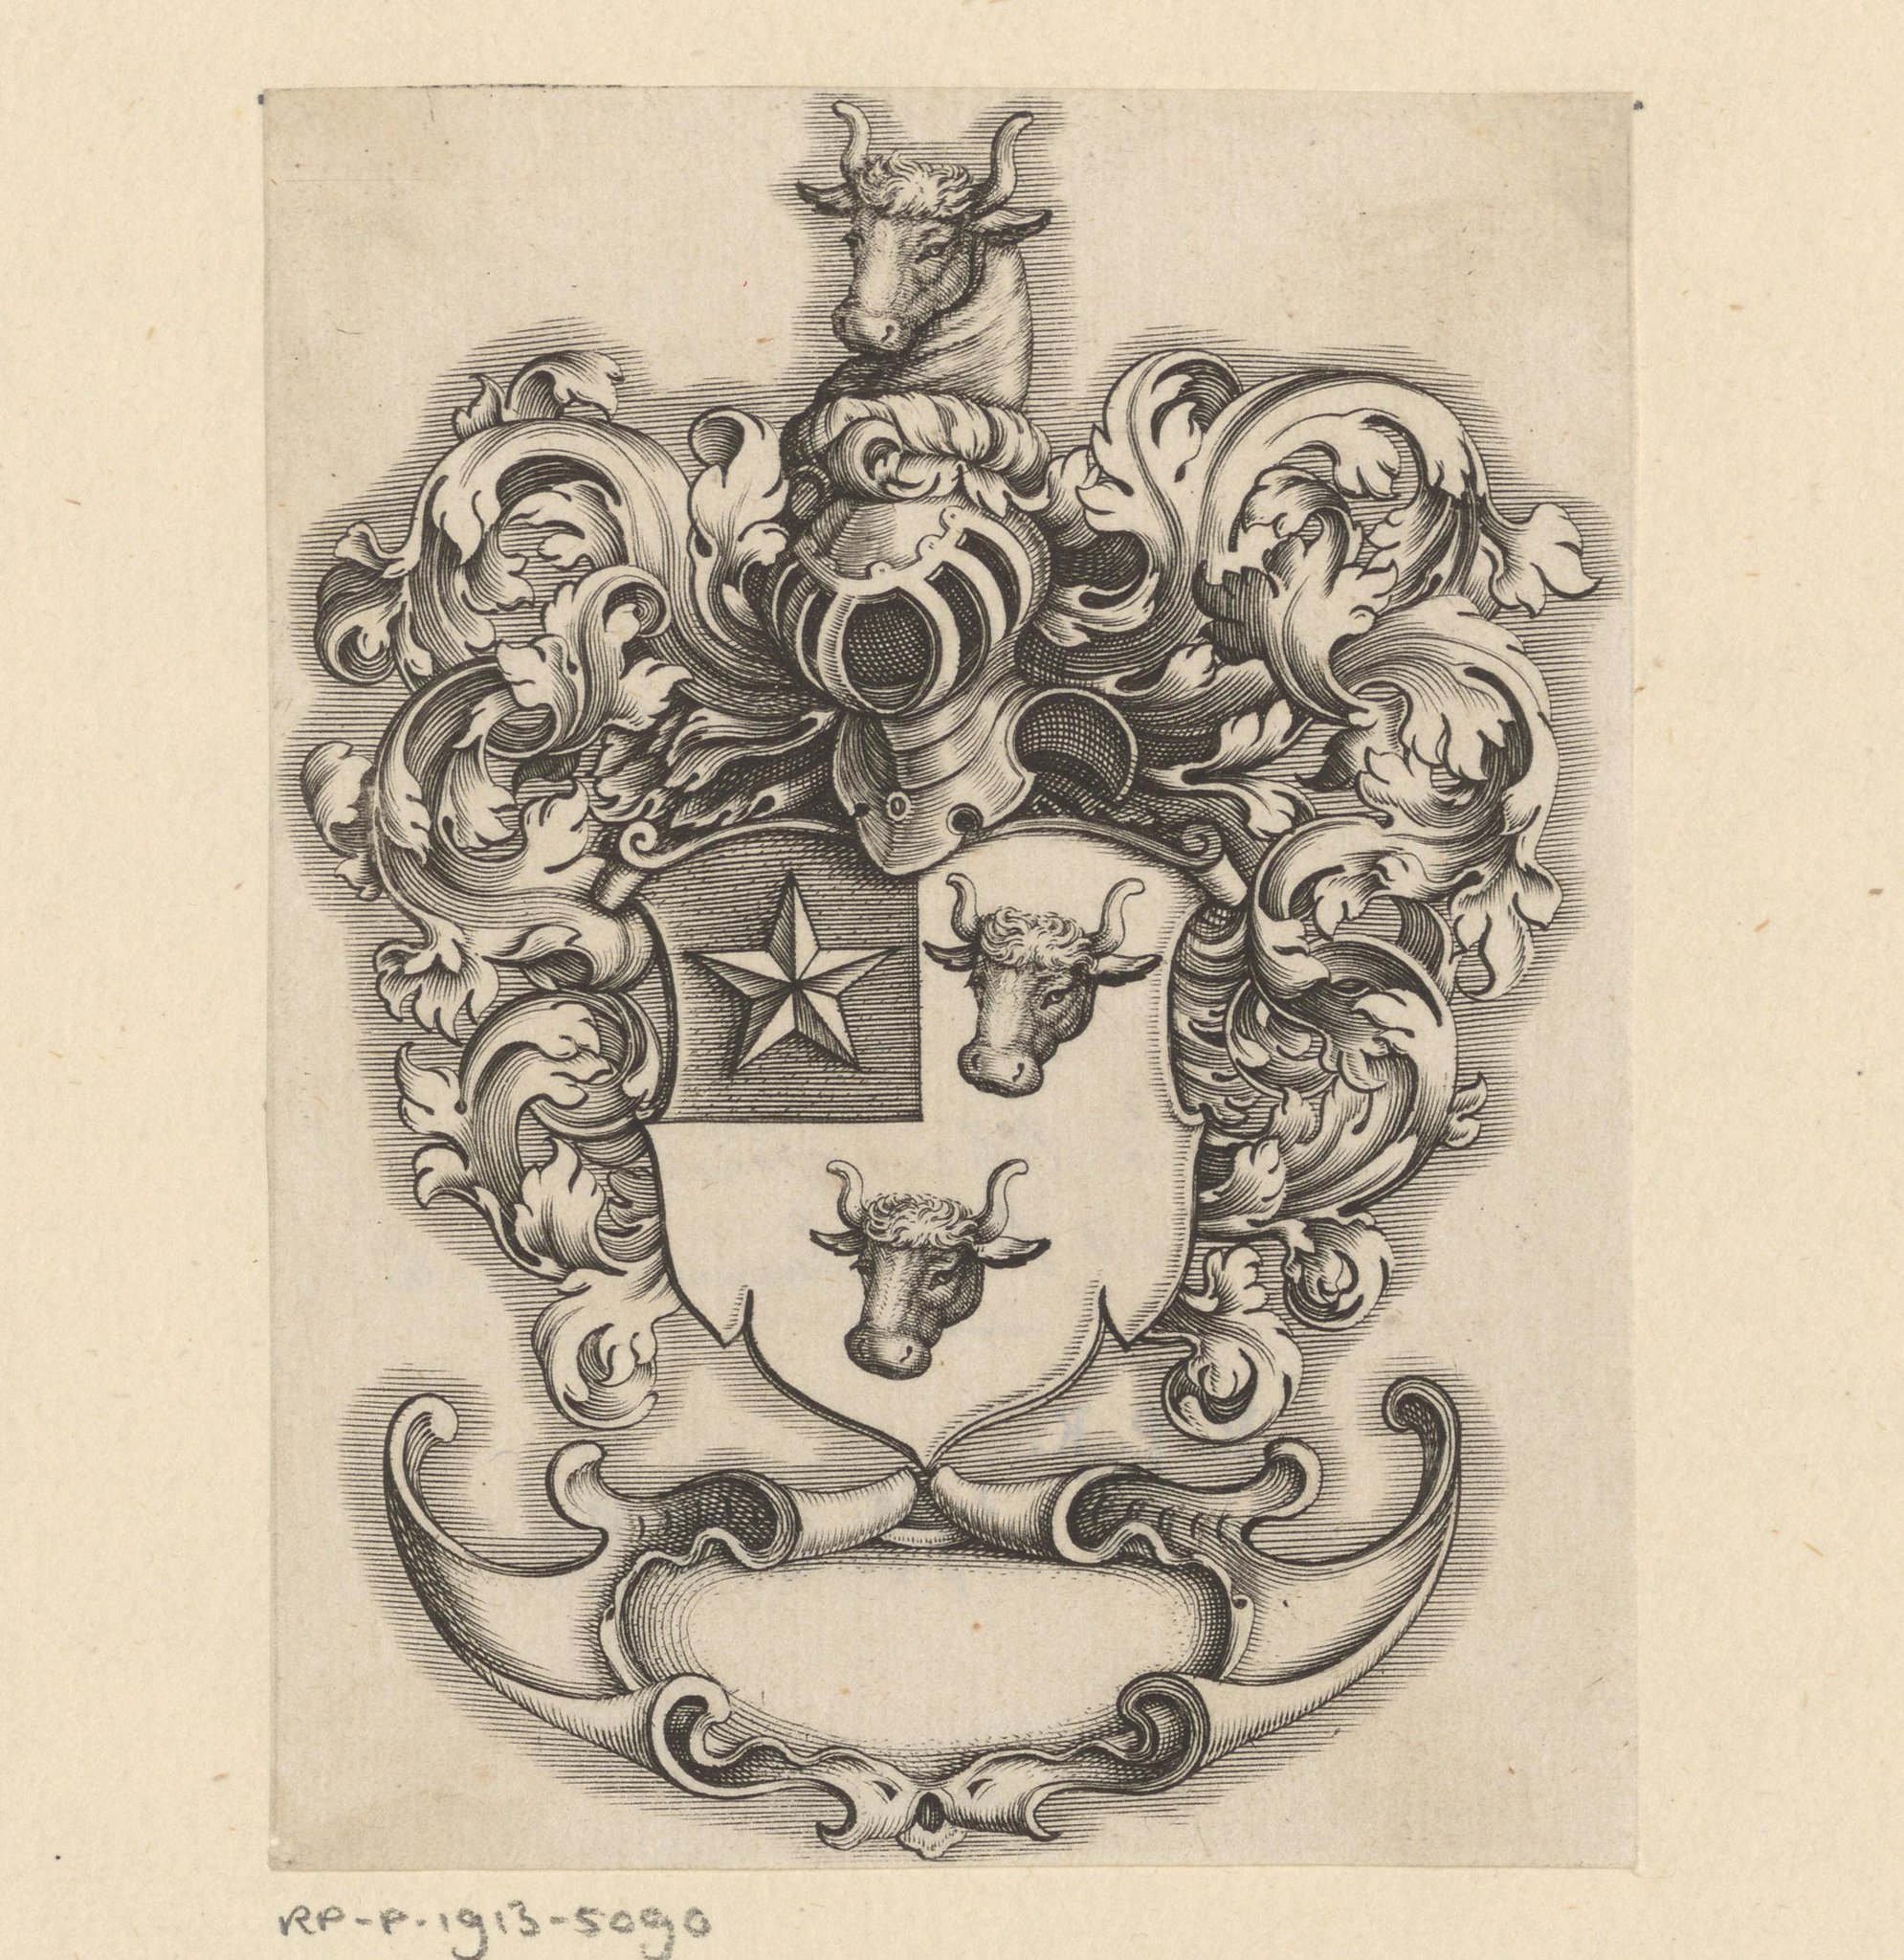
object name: bookplate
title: Ex libris van Dirck van Os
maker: michiel le blon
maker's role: print maker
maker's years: 1587-1656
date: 1597-1656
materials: paper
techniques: engraving, etching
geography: netherlands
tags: antwerp, stars, ox, armorial bearing, heraldry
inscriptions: collector's mark: Lugt 2760, inscription: ‘Dirk van Os / Michiel Le Blond sc. vdK n. / 1587-1656’, collector's mark: Lugt 2233, inscription: ‘Ex libris genomen (?) / uit U660 Emm[...] (?)’